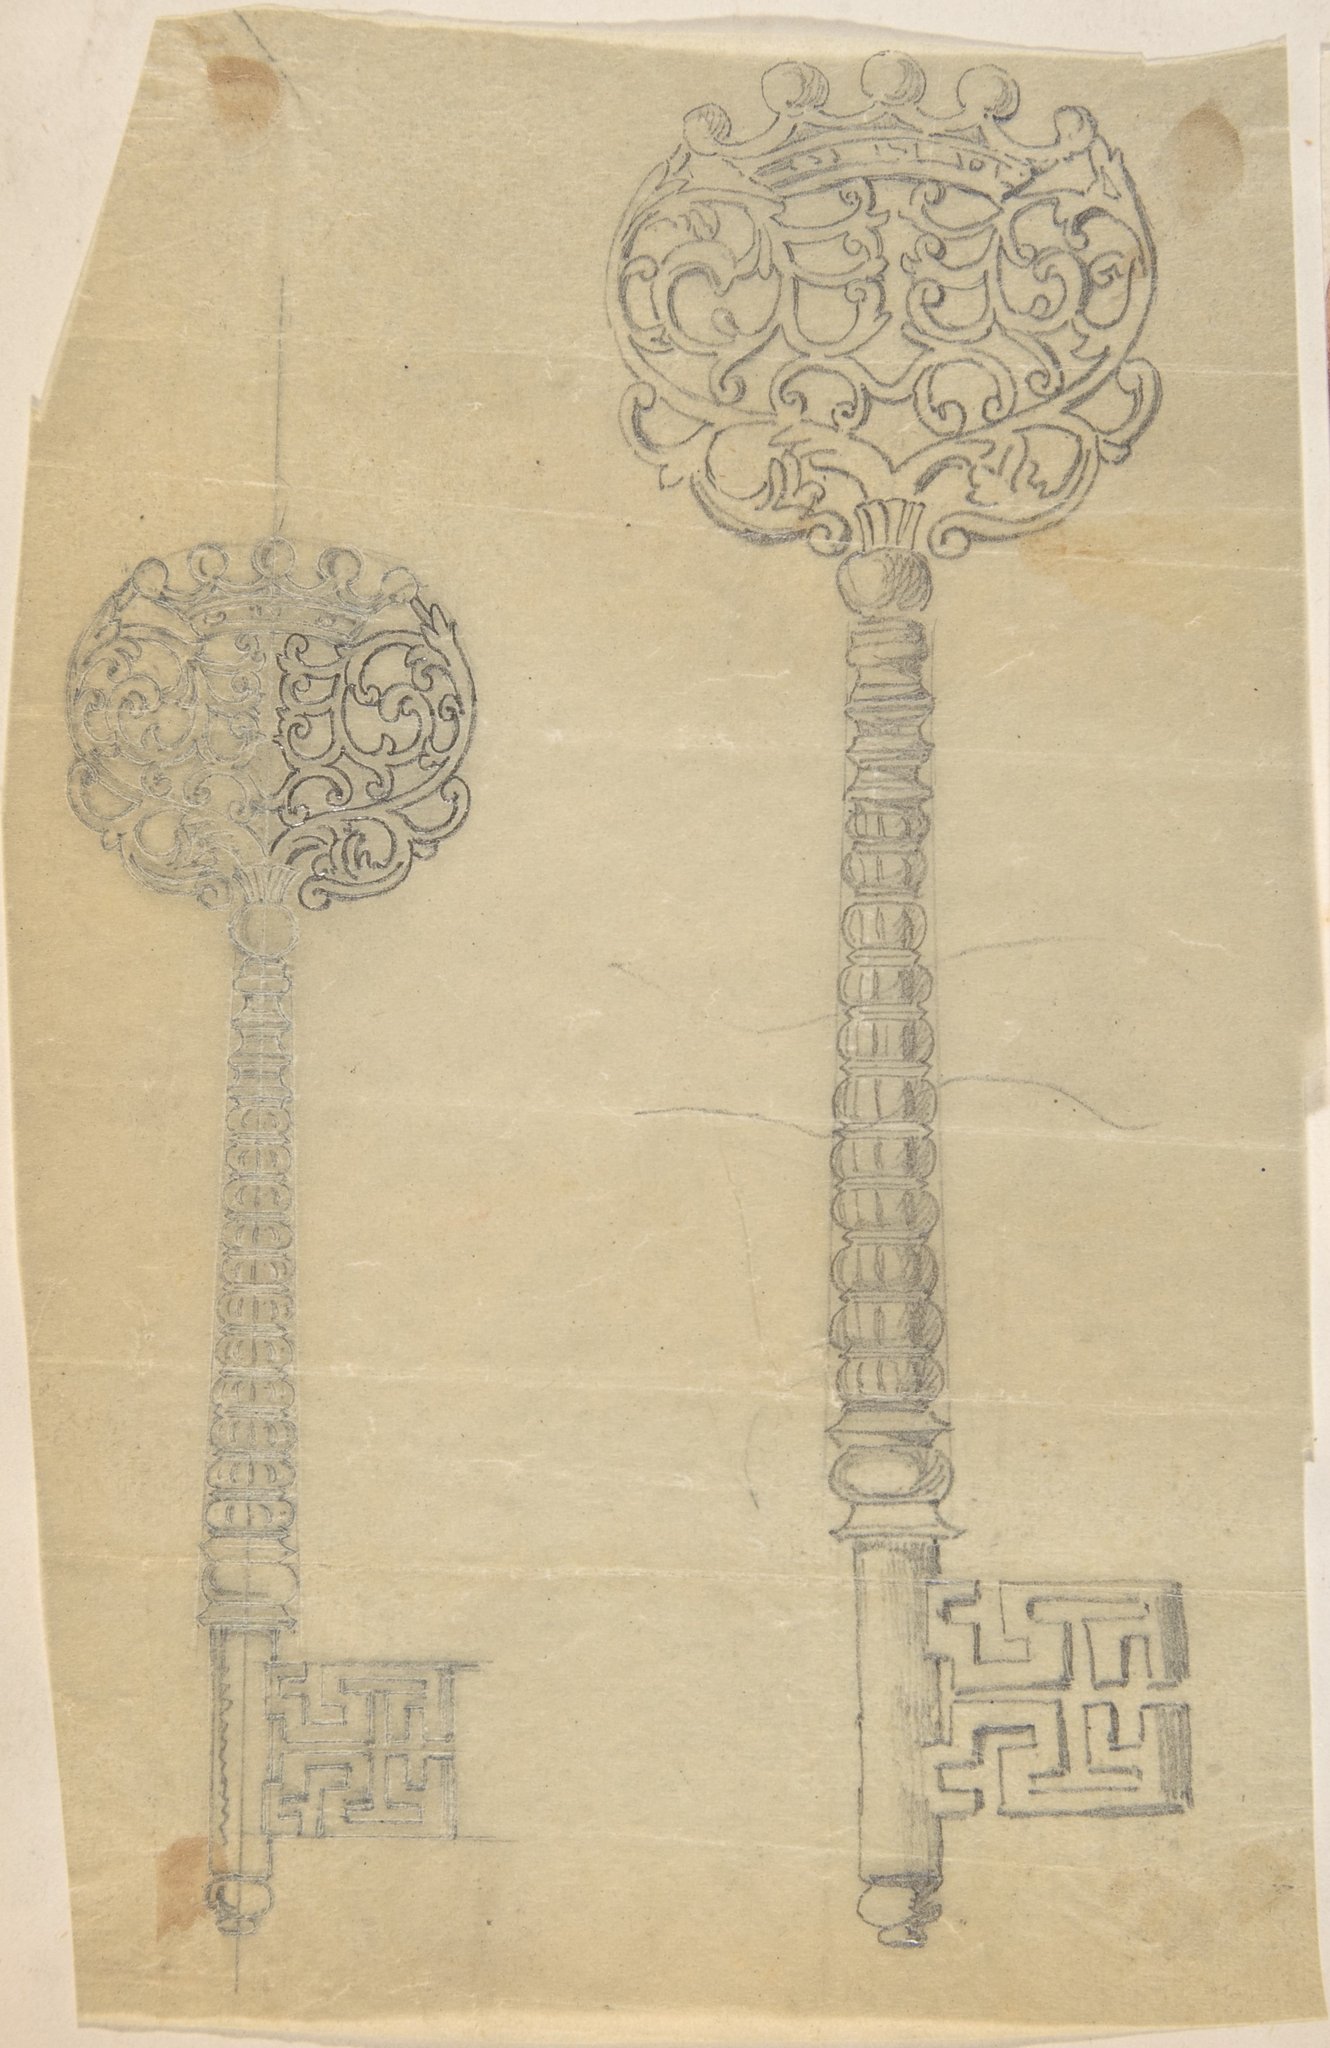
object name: drawing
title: Keys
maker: anonymous, british, 19th century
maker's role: artist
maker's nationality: british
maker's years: 1800-1900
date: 1851-1900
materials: graphite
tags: ornament,keys